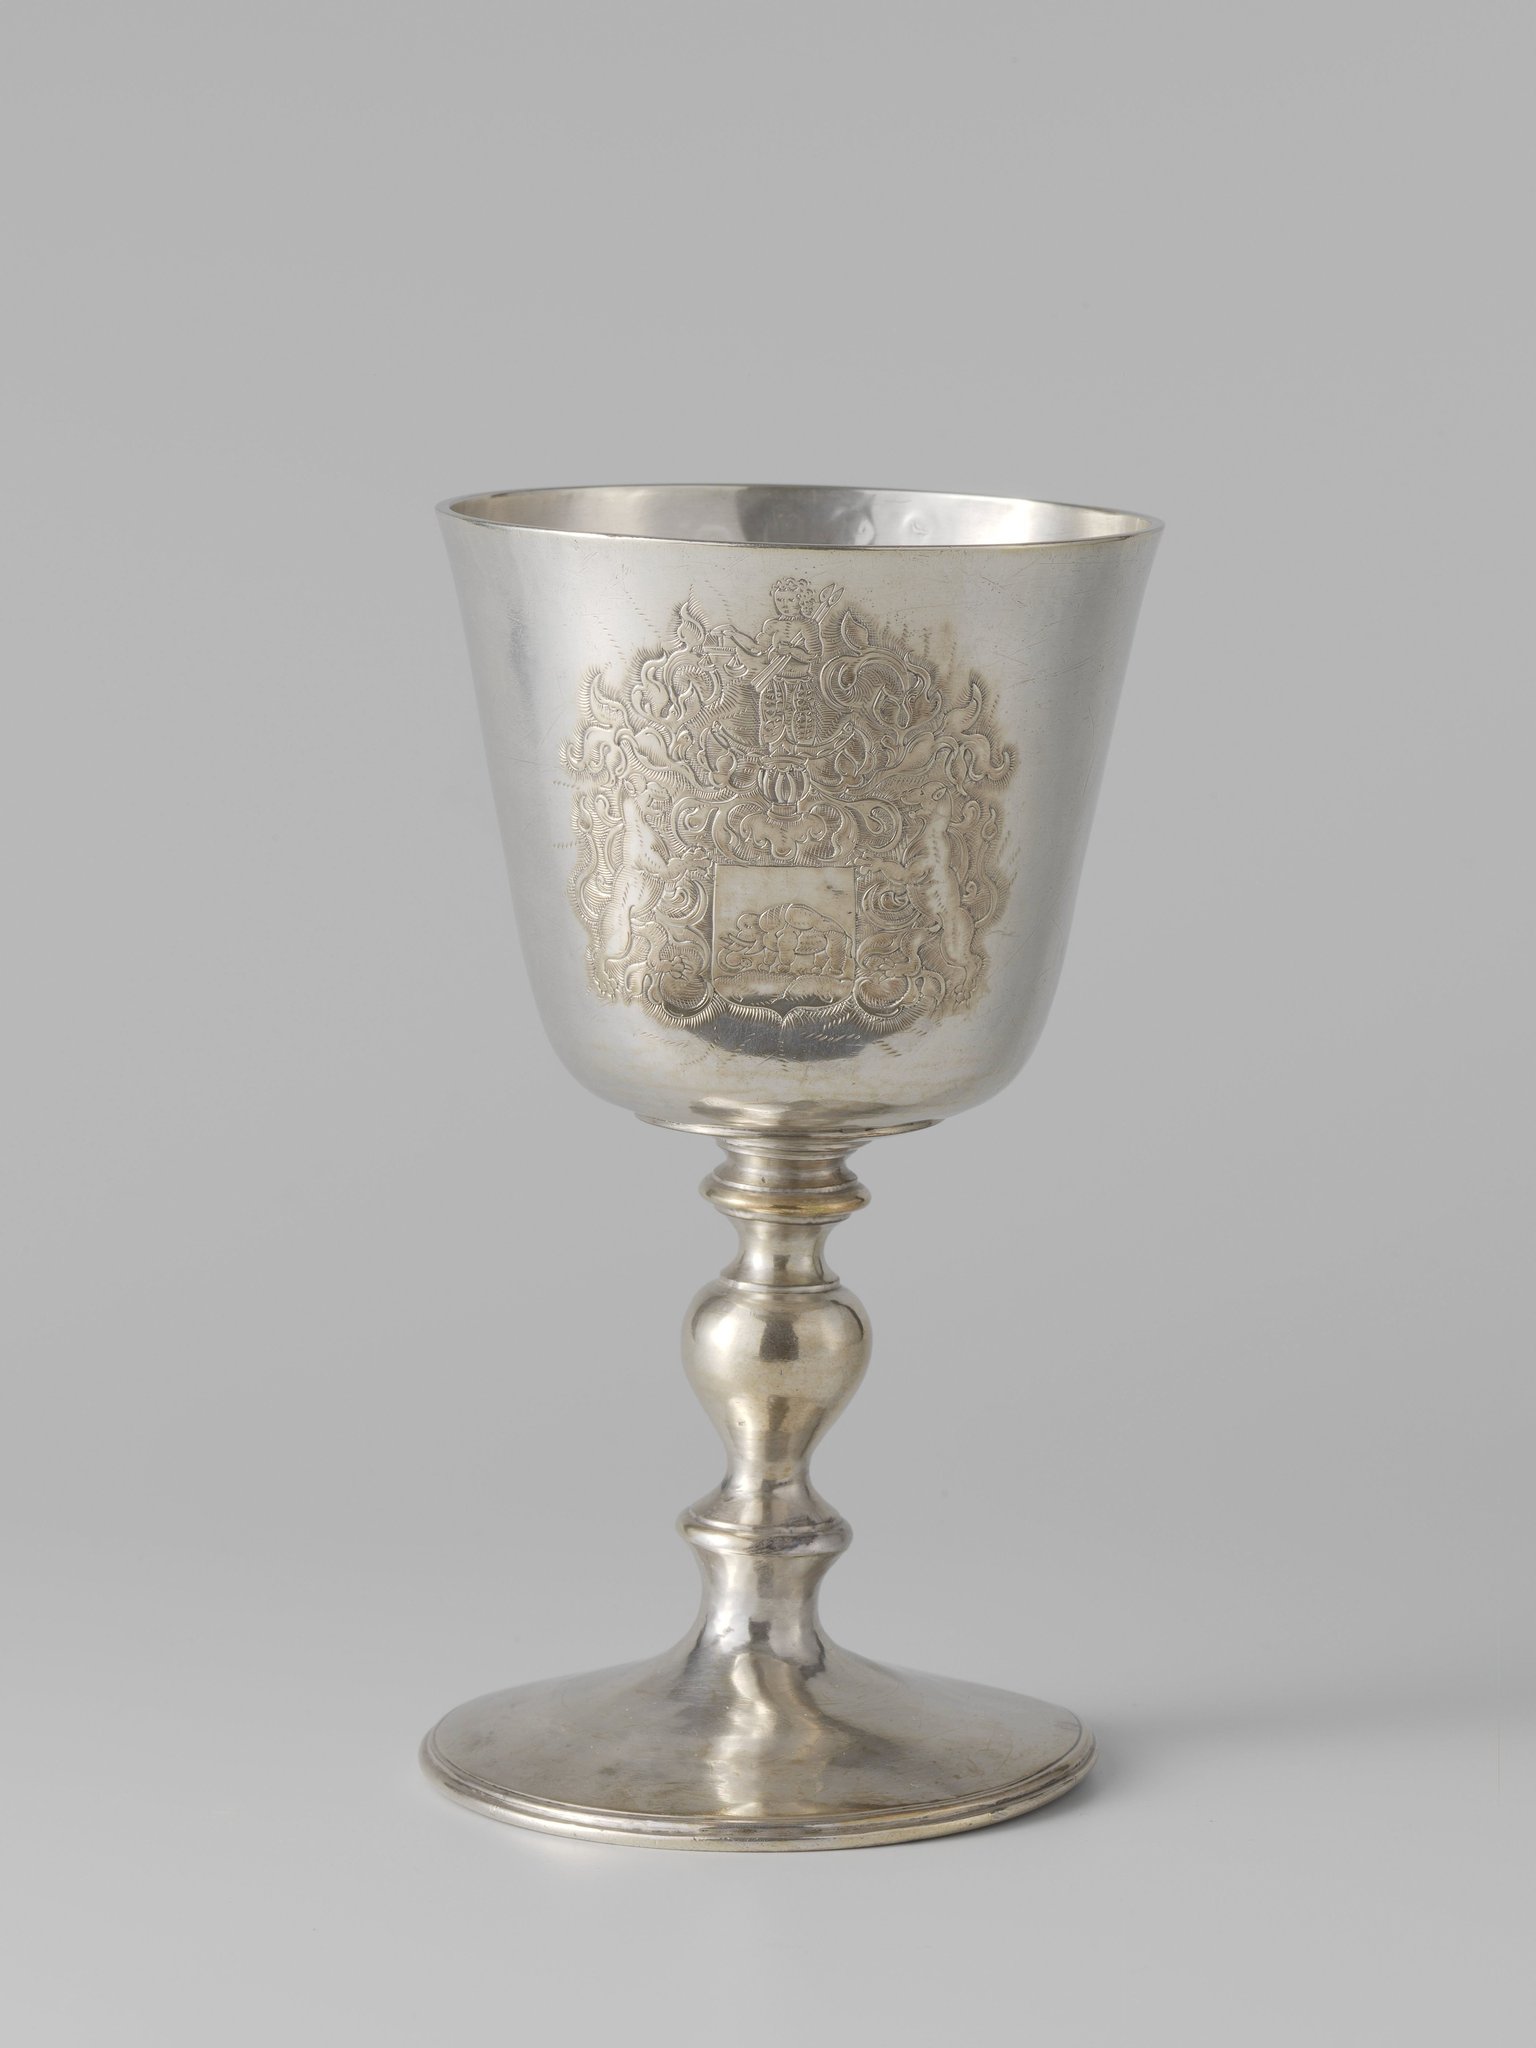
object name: communion cup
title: Beker uit het Nederlandse fort van St. George d'Elmina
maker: Anonymous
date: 1638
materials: silver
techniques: engraving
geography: london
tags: coat of arms (as symbol of the state, etc.) (+ city; municipal)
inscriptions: mark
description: Chalices, 1638. Shortly after the Dutch captured Fort El Mina from the Portuguese in 1637, these goblets were commissioned in London. They were used in the fort's small Dutch Reformed church until 1872, when the fort was ceded to the British Empire. The goblets are decorated with the arms of El Mina: a shield depicting an elephant.